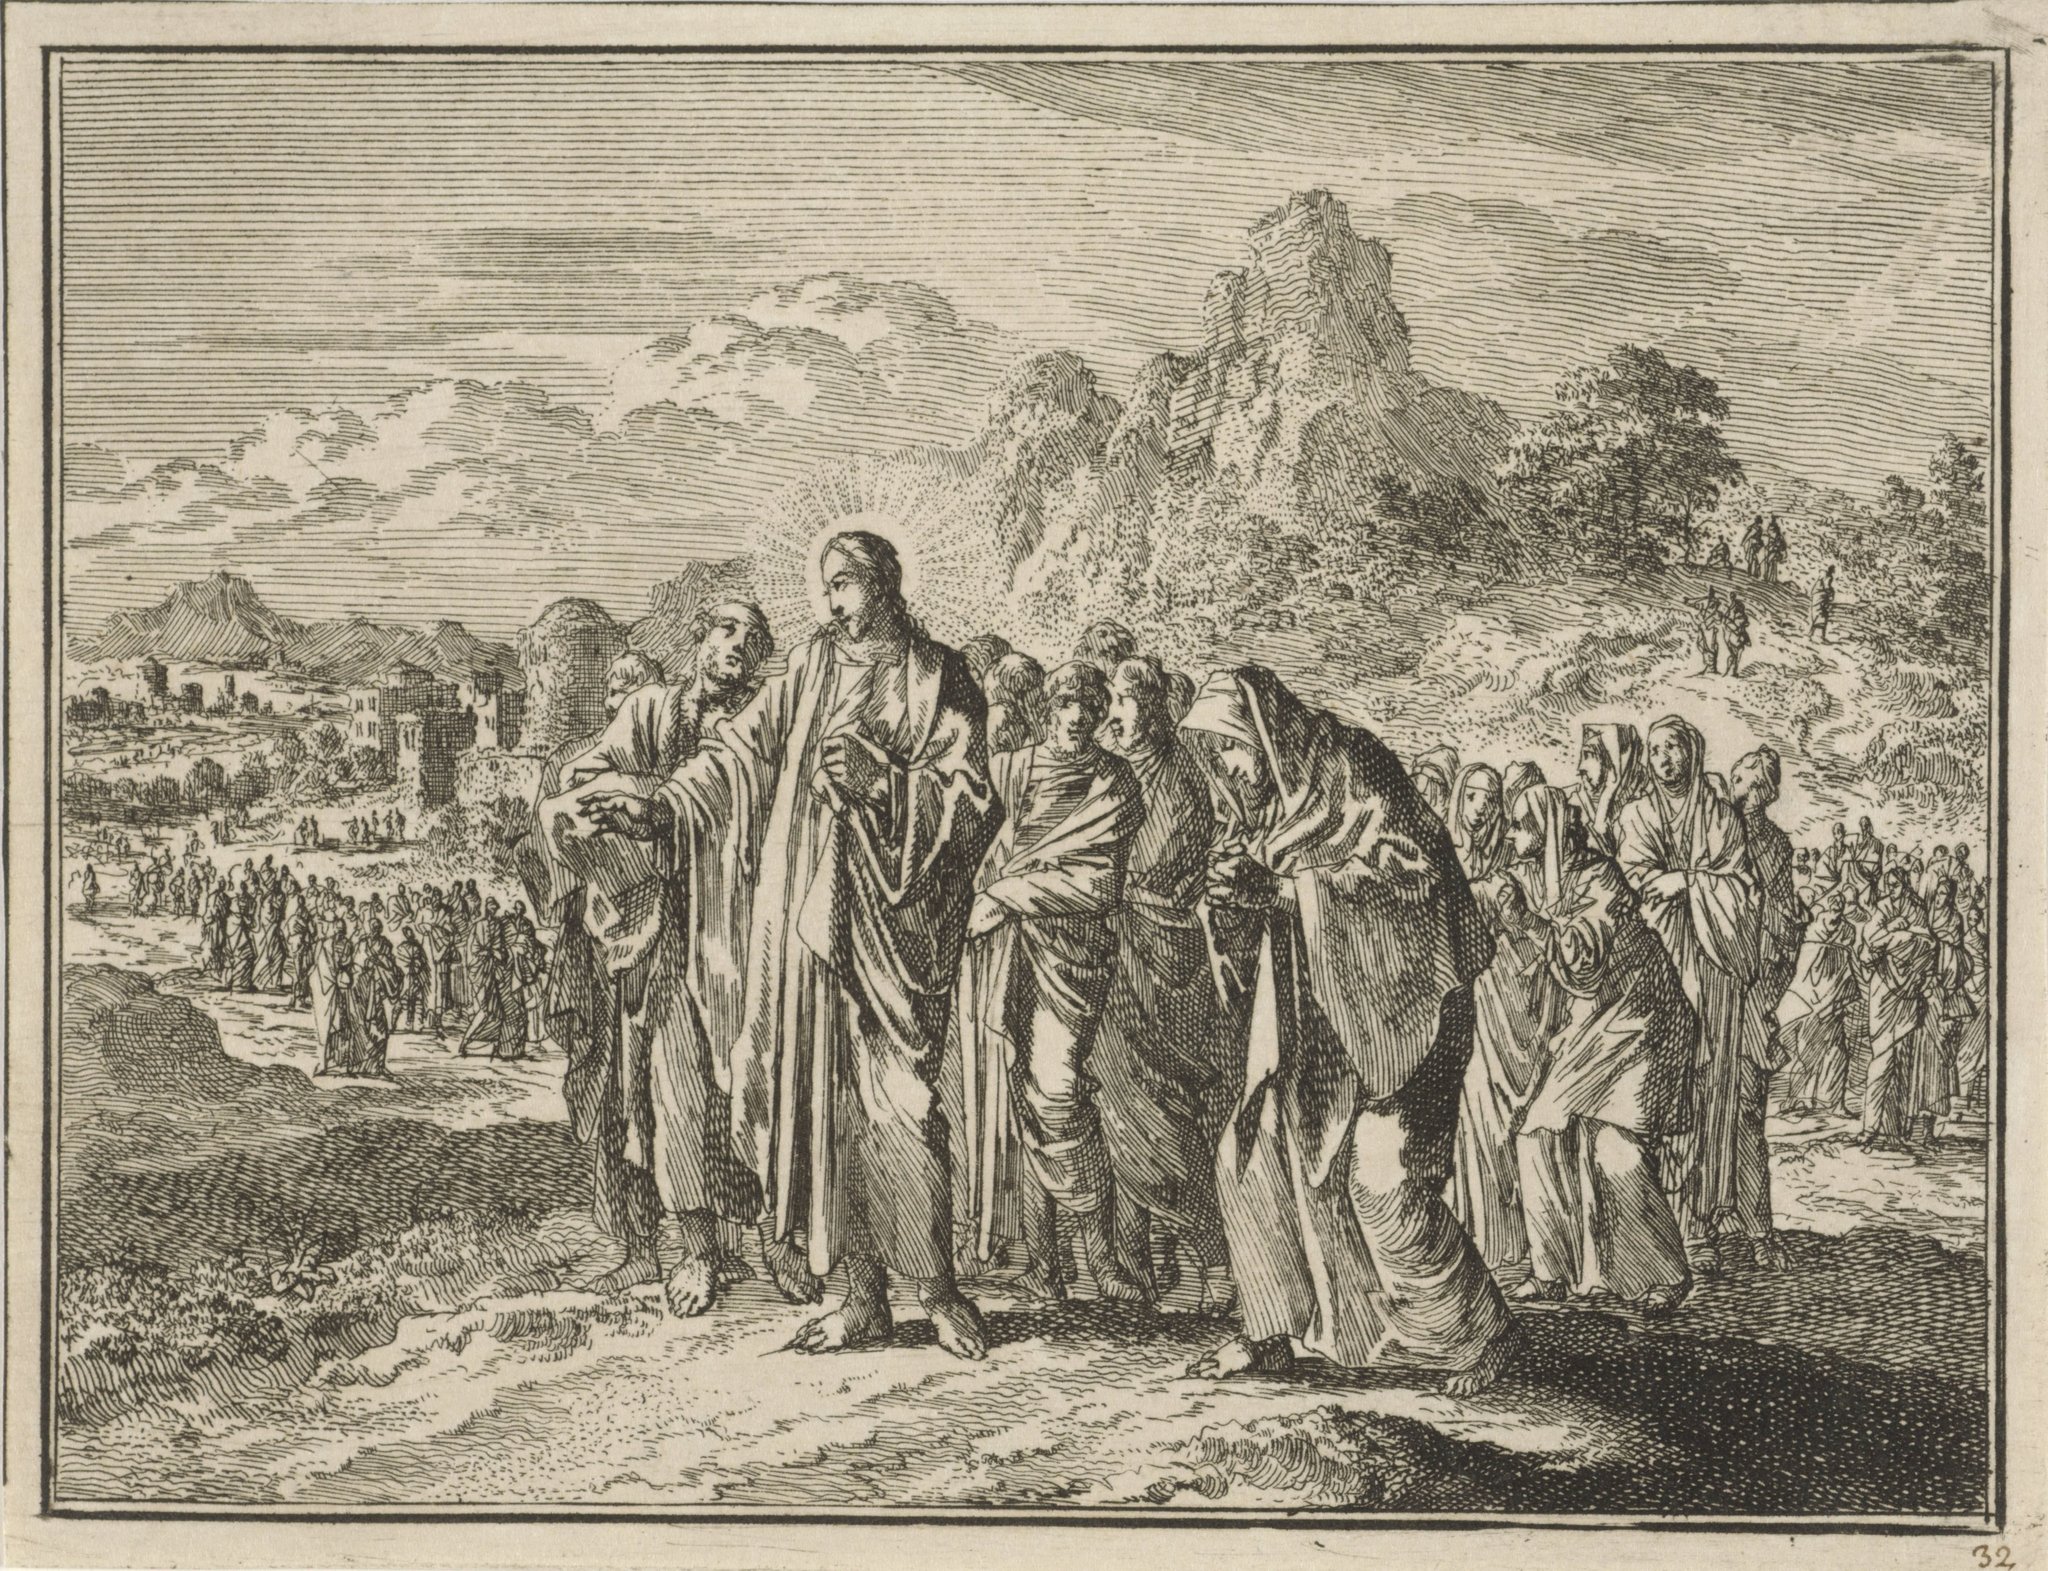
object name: print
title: Christus gevolgd door zijn discipelen en een aantal vrouwen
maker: jan luyken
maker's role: draughtsman, print maker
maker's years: 1649-1712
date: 1712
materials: paper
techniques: etching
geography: amsterdam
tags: christ explaining his doctrine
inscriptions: collector's mark: Lugt 2228, number: ‘32’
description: Proefdruk van illustratie uit: Luyken, Jan. De schriftuurlyke geschiedenissen en gelykenissen van het Oude en Nieuwe Verbond, 2 delen. Amsterdam: Wed. Pieter Arentsz II en Cornelis van der Sys, 1712, dl. II.